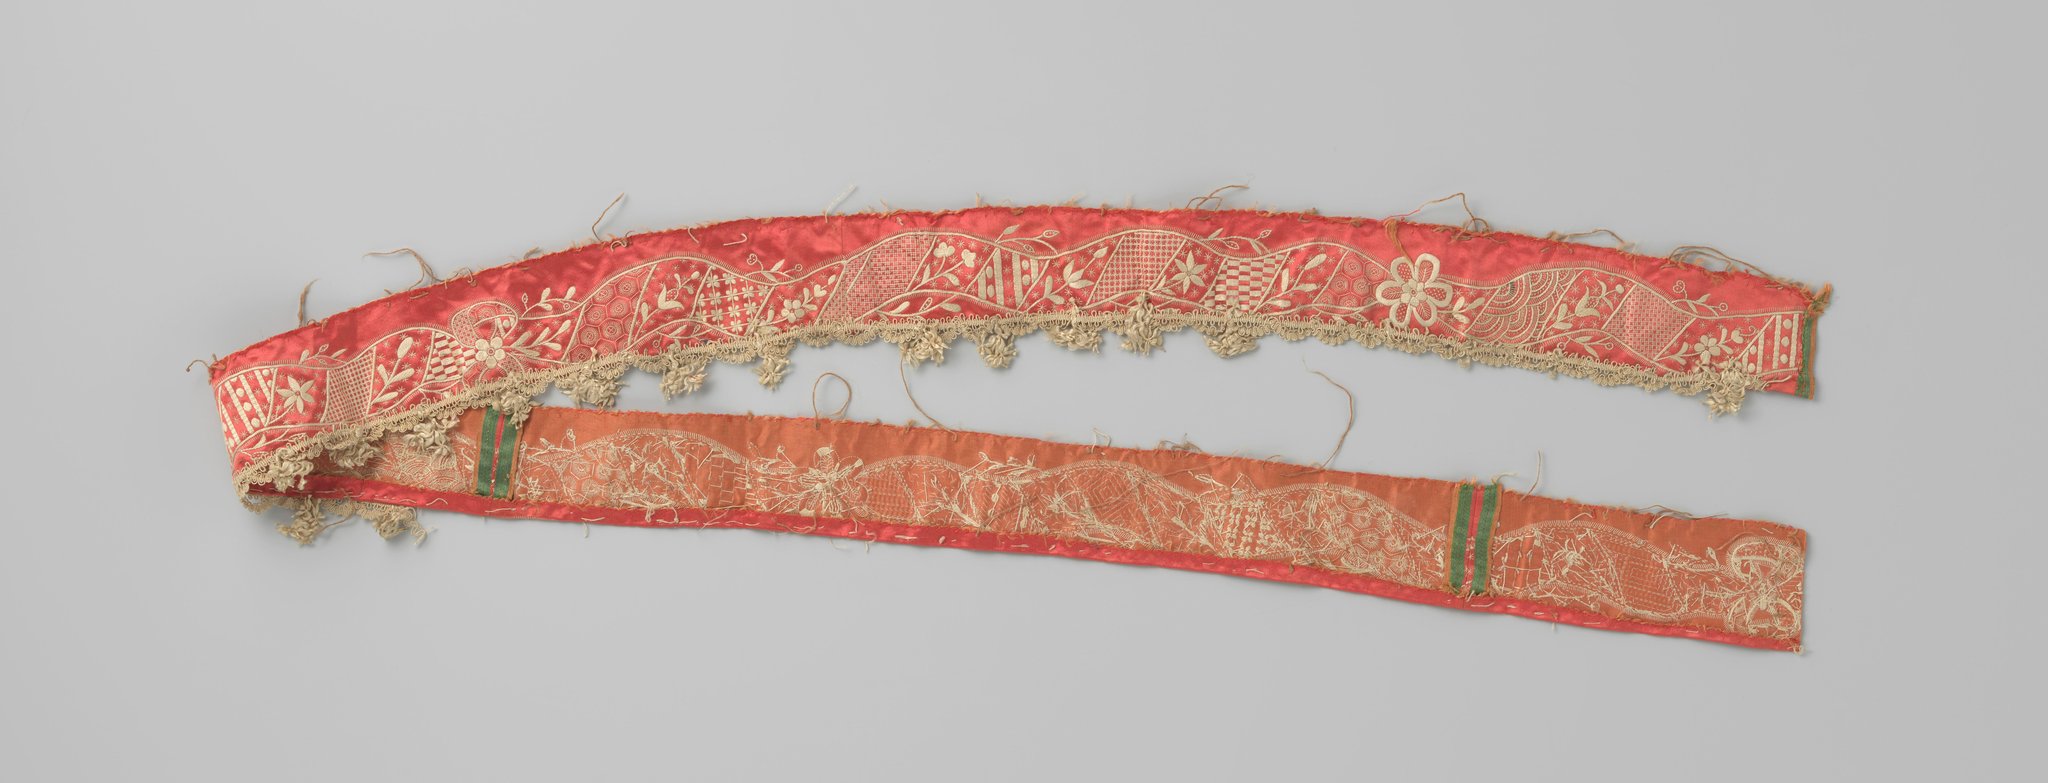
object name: cloth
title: Embroidered Interior Textile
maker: Anonymous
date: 1750-1760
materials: silk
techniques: embroidered, weave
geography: france